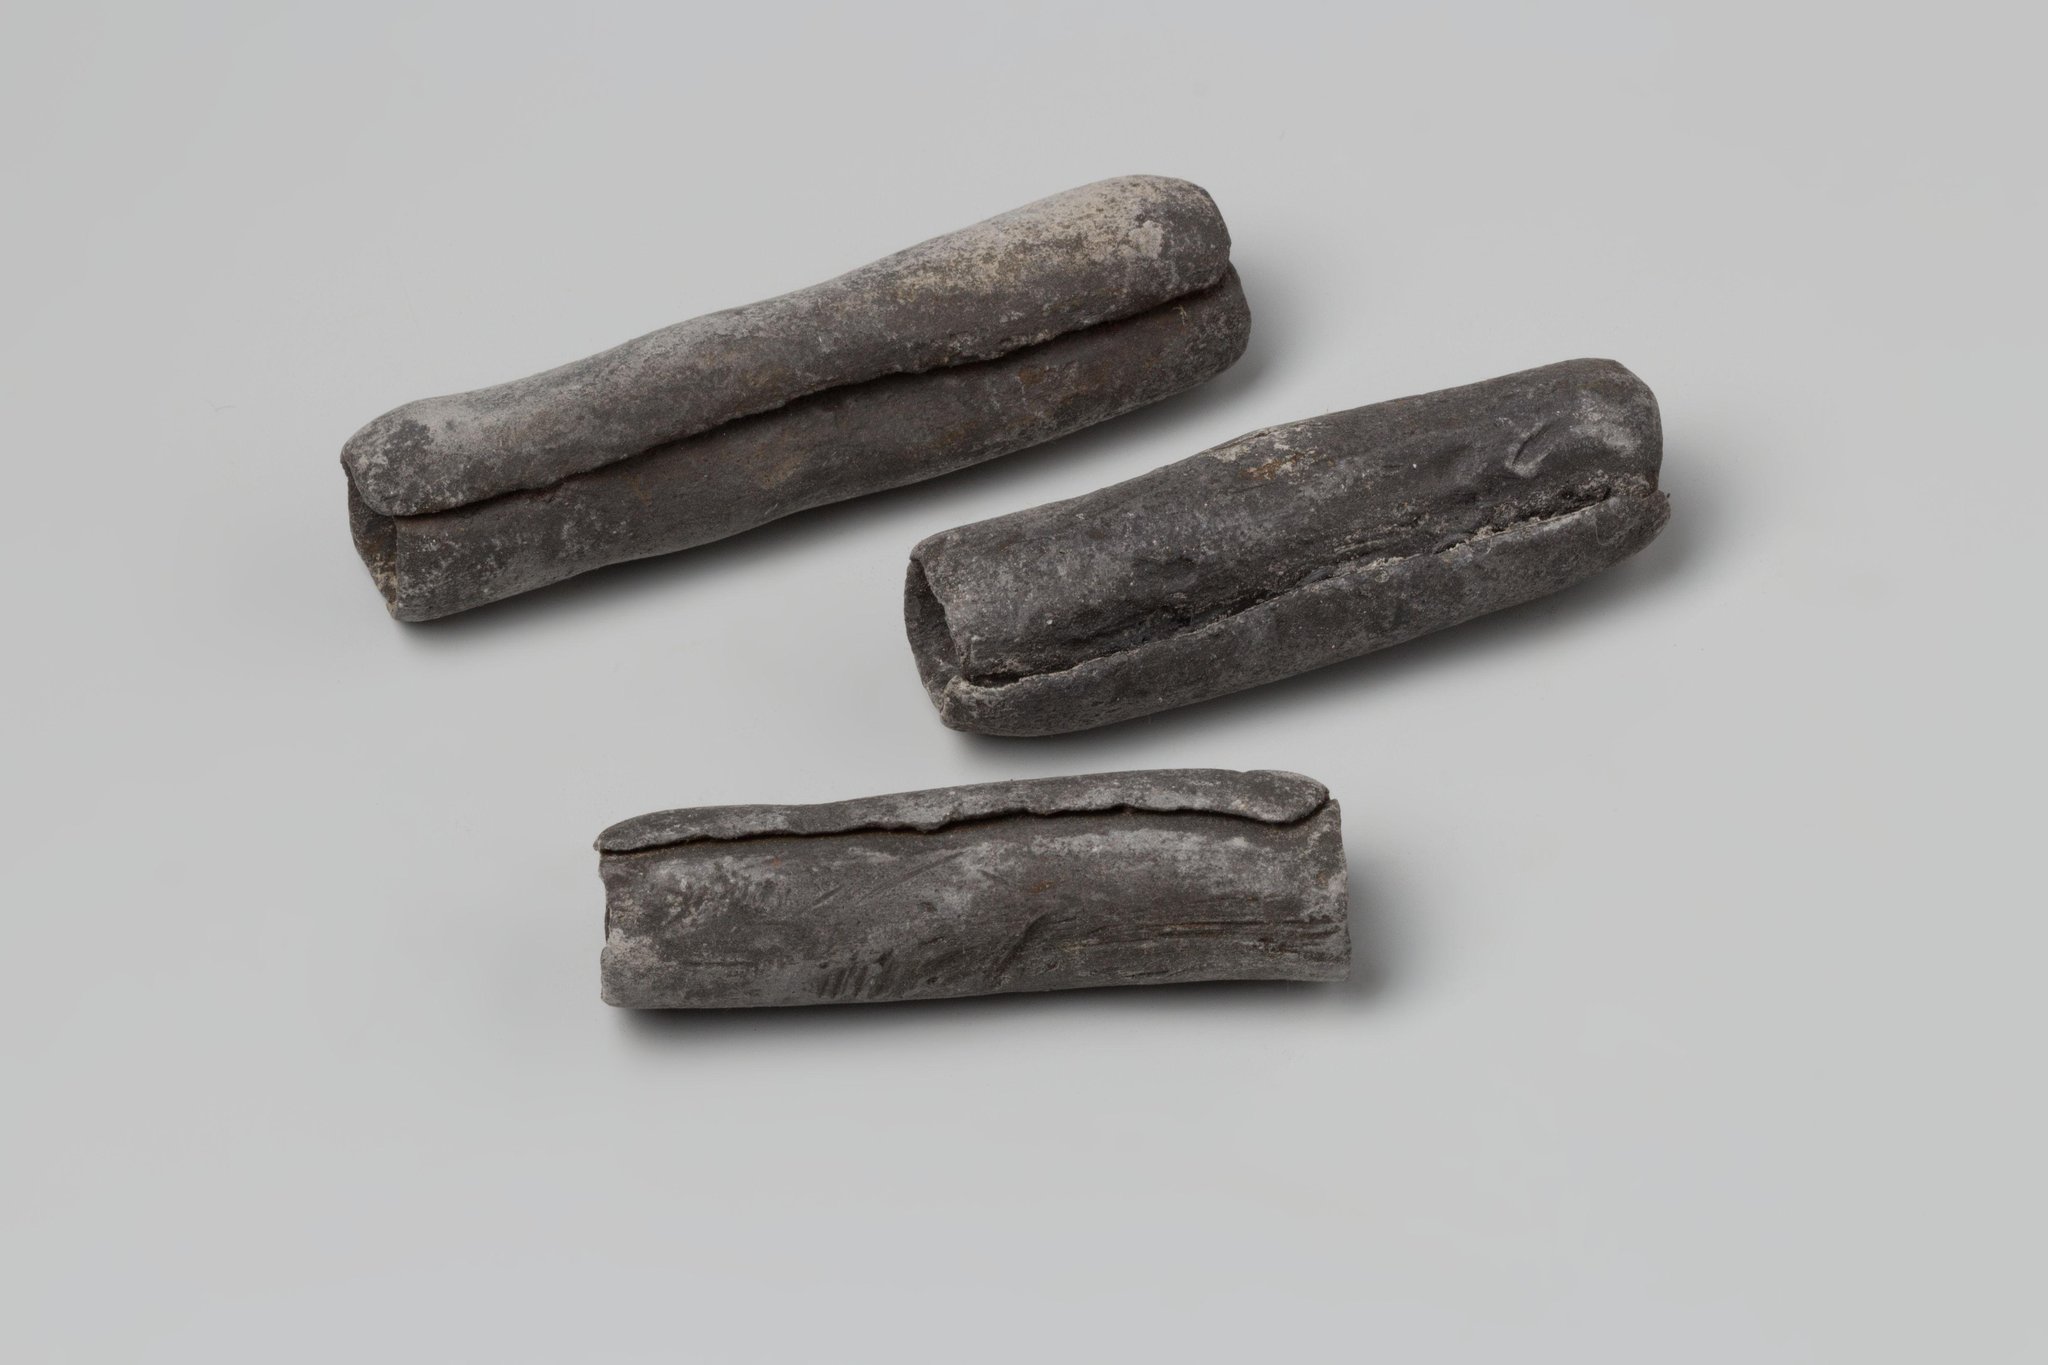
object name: lead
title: Loden rol uit het wrak van de Oost-Indiëvaarder 't Vliegend Hart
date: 1700-1735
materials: lead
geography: middelburg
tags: 't vliegend hart (schip), verenigde oostindische compagnie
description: Deze loden buisjes zijn vermoedelijk afkomstig van visnetten ofwel op TVliegend Hart zelf ofwel van vissers die hun netten aan het wrak verloren.